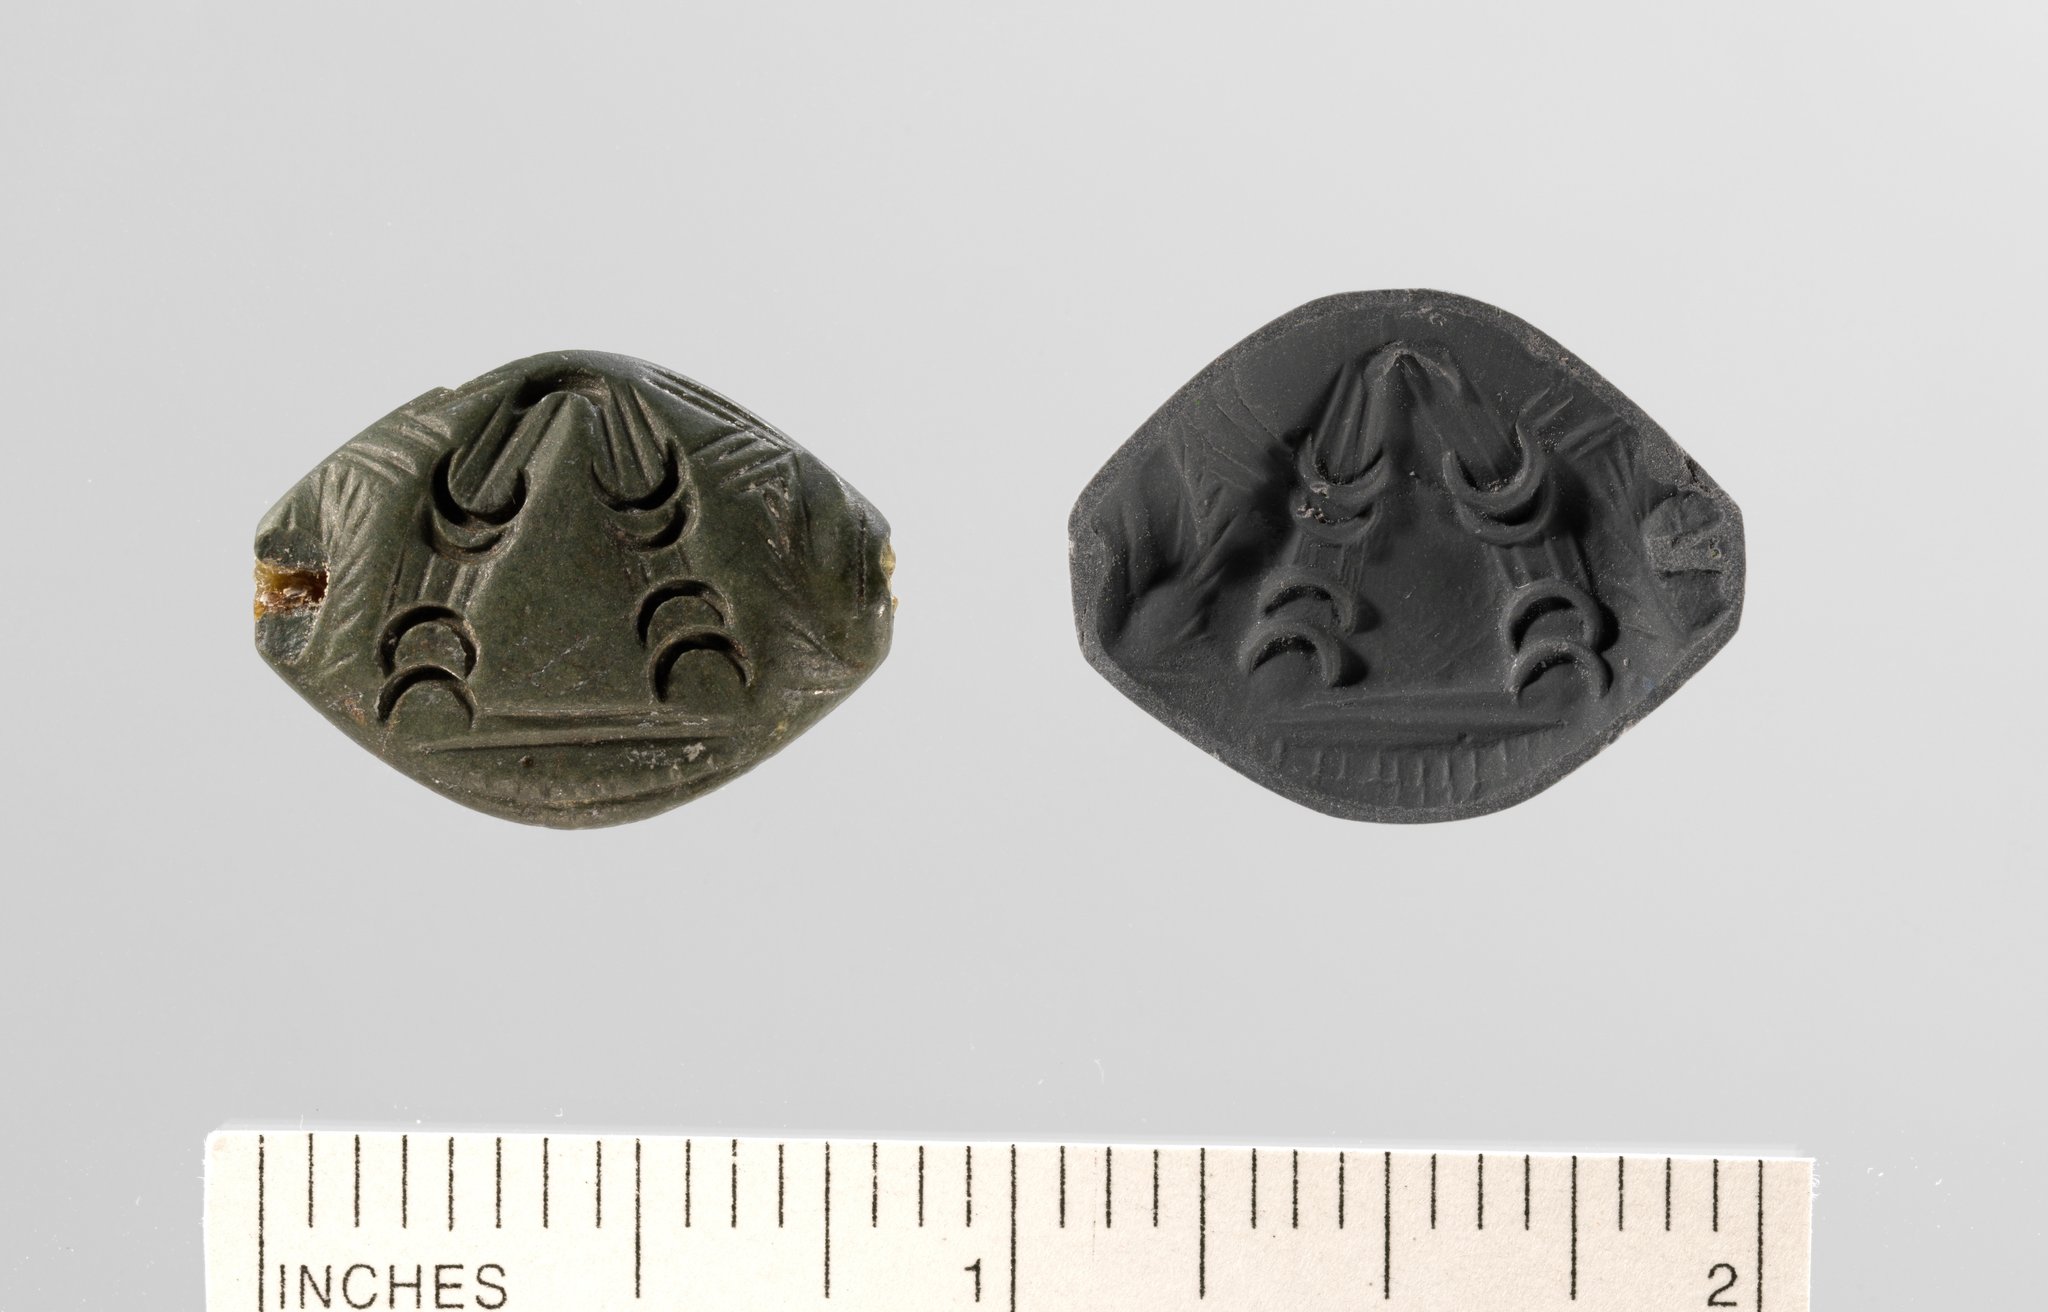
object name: seal, amygdaloid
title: Marble Amygdaloid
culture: minoan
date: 1650-1500 BCE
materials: marble